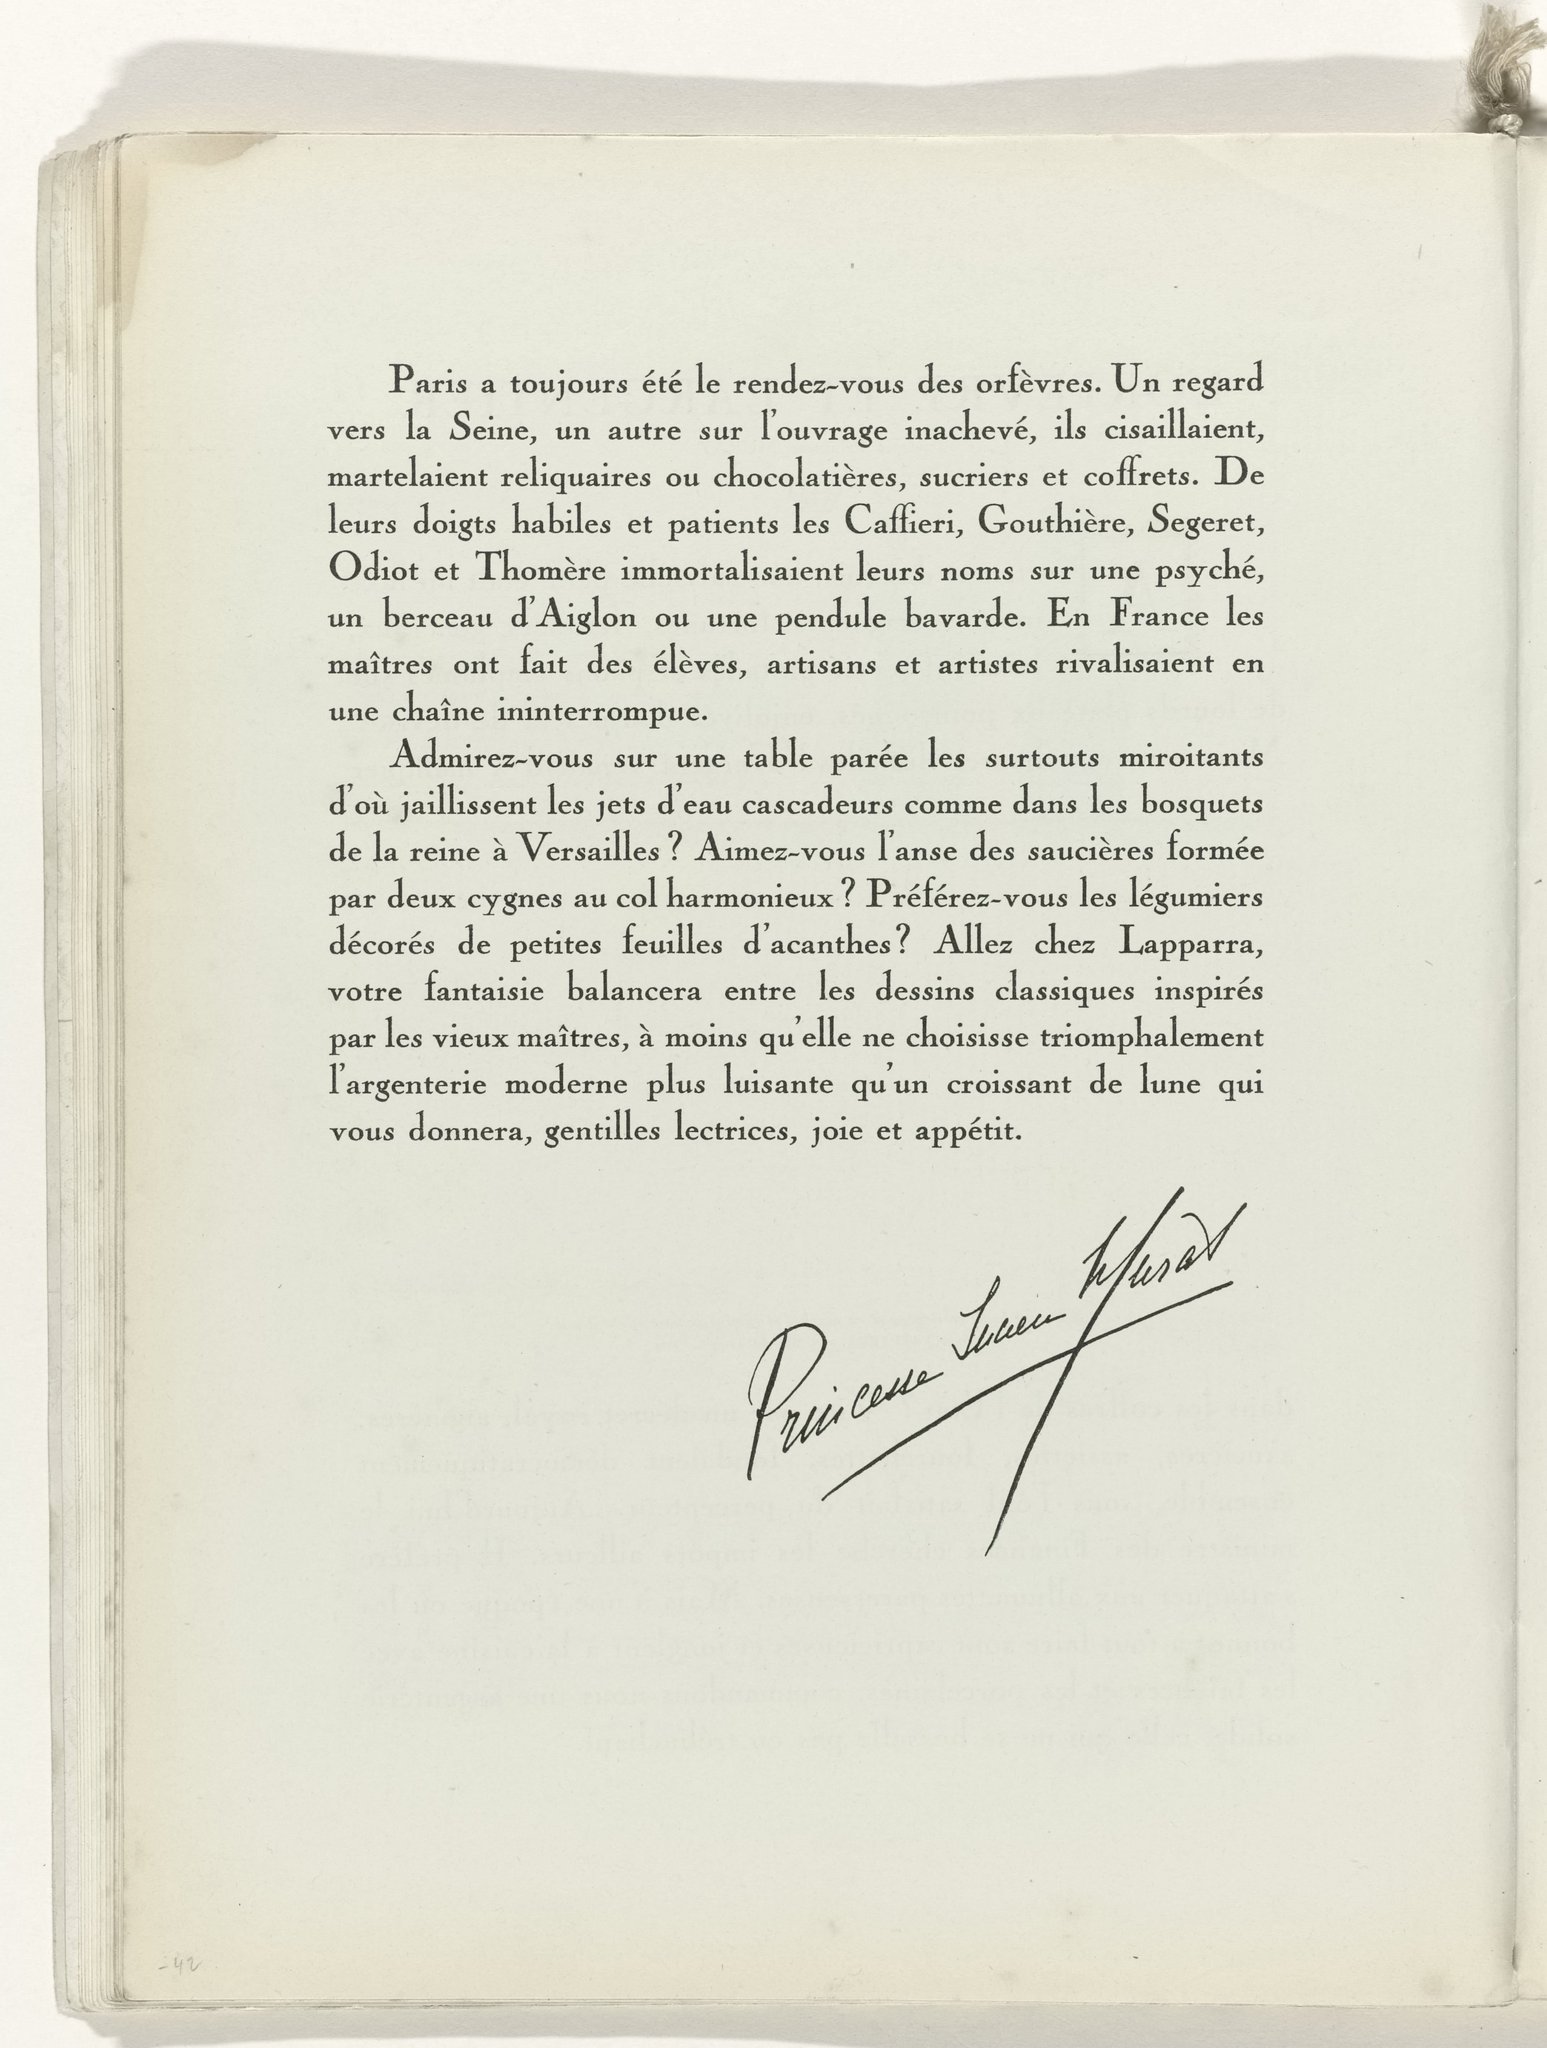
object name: magazine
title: Art - Goût - Beauté, Feuillets de l' élégance féminine, Noël 1928, No. 100, 9e Année, p. 42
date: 1928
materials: paper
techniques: lithograph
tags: fashion plates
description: Vervolg tekst van 'L'orfévre et l 'argentier'. Pagina uit het modetijdschrift Art-Goût-Beauté (1920-1933).